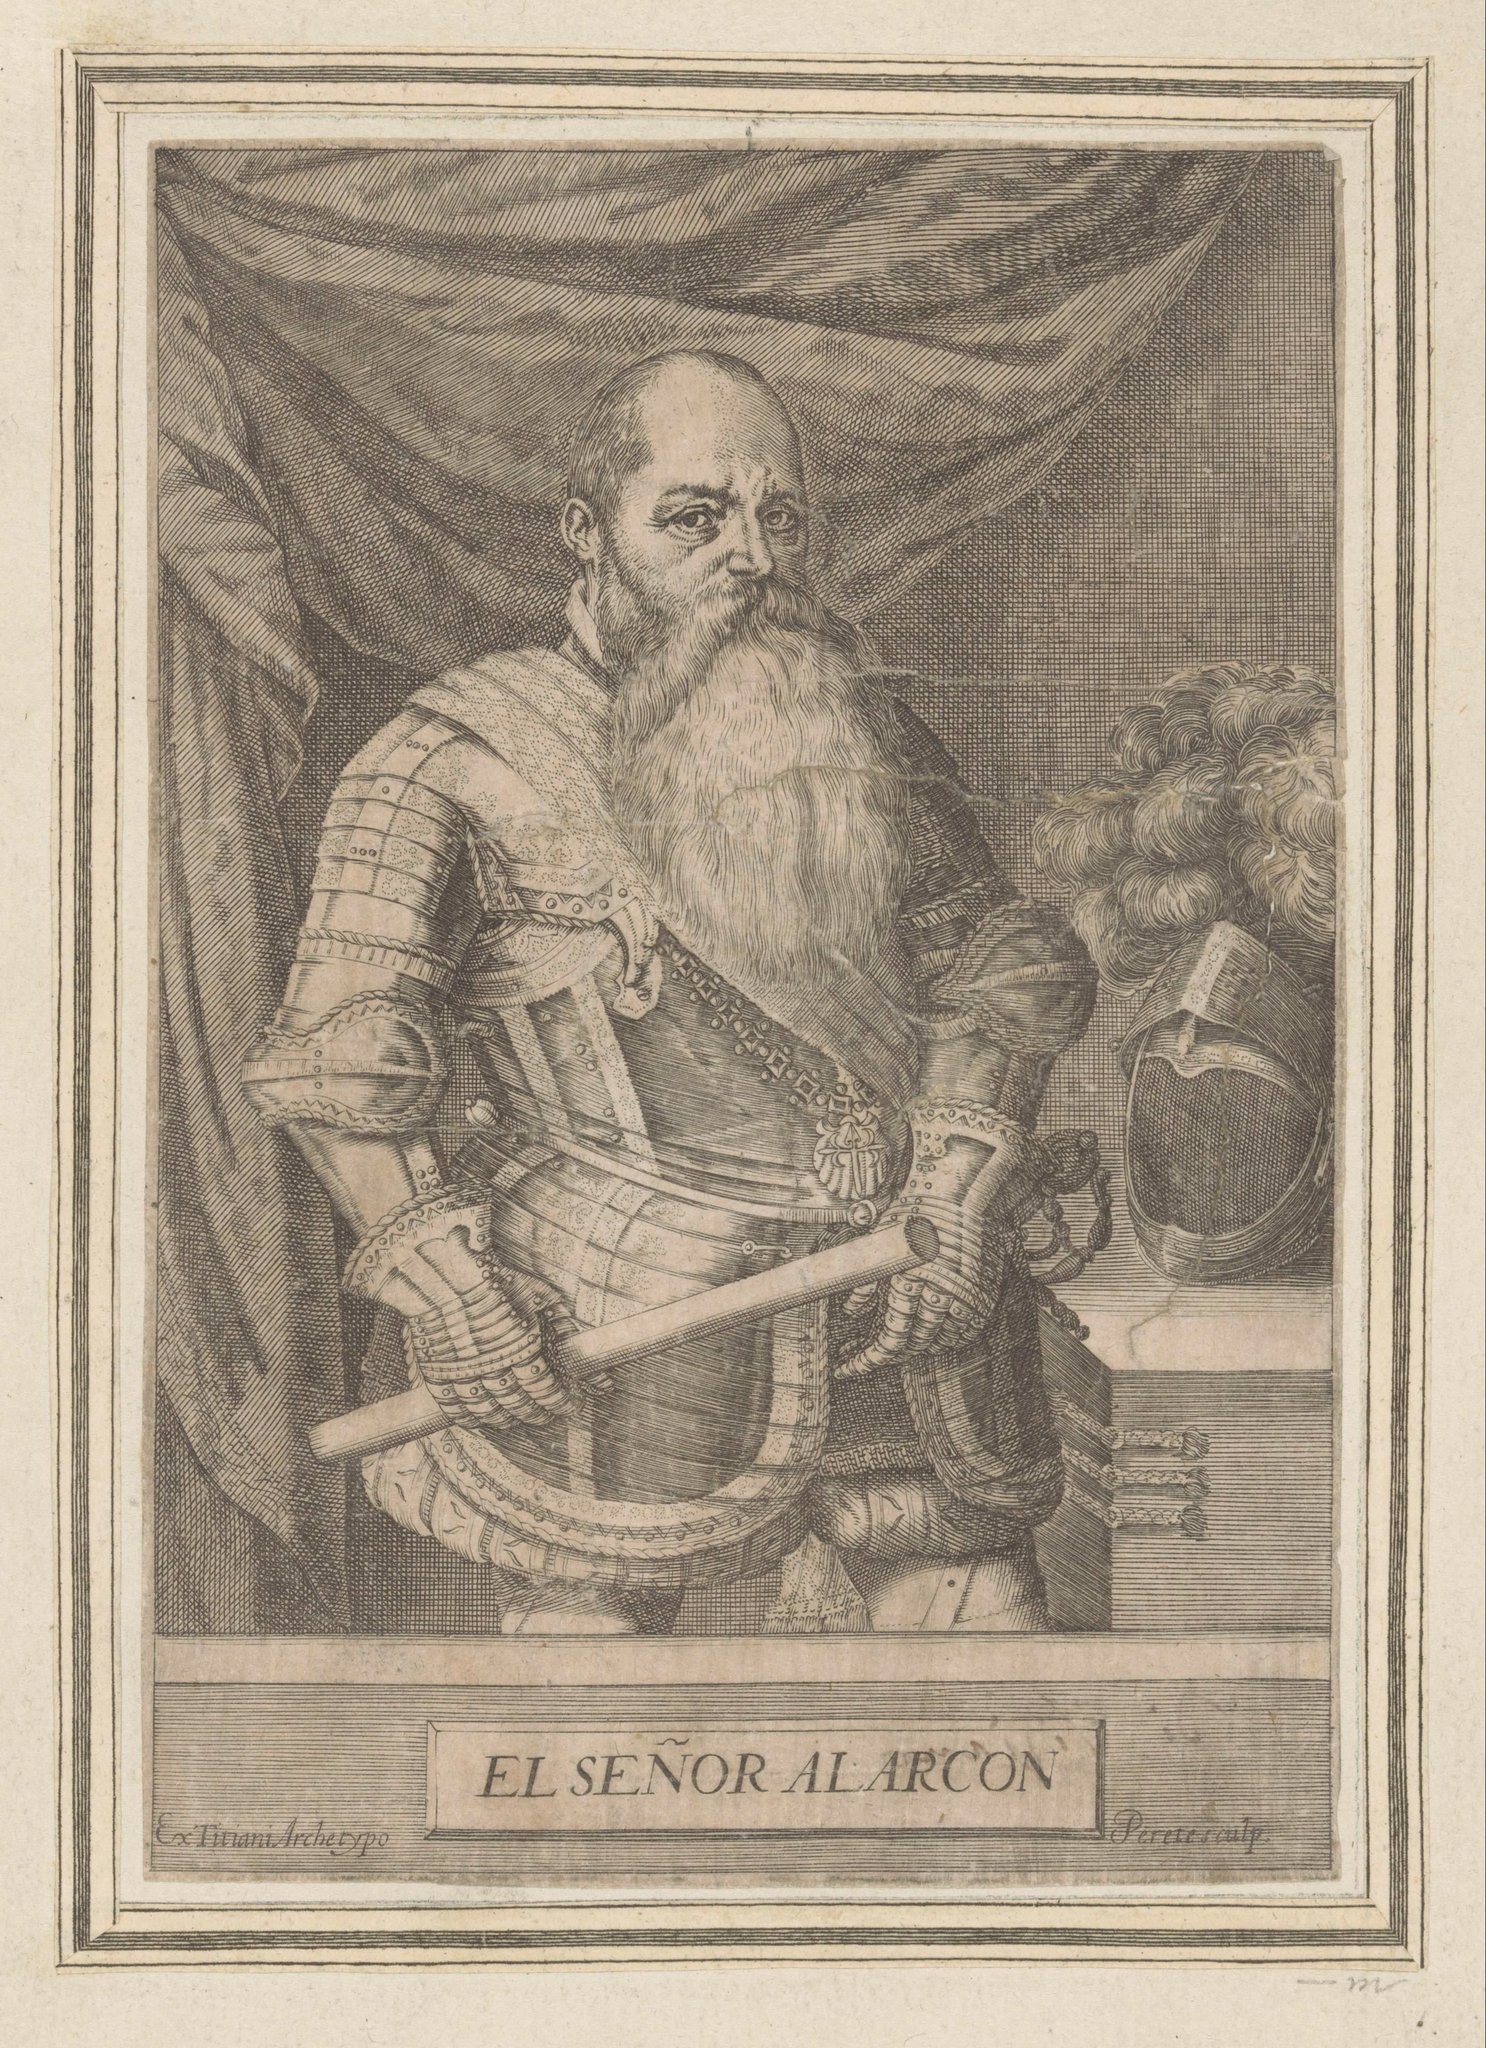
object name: print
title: Portret van Hernando de Alarcón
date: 1565-1639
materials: paper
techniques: engraving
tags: trujillo, alta california, ontdekkingsreiziger, hernando de alarcón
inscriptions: collector's mark: Lugt 2228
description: Portret van Hernando de Alarcón. Hij draagt een harnas en heeft een commandostaf in zijn rechterhand. Op de achtergrond zijn gepluimde helm. In een kader zijn naam. Geheel in een afzonderlijk gegraveerde, los opgeplakte, rechthoekige omlijsting.